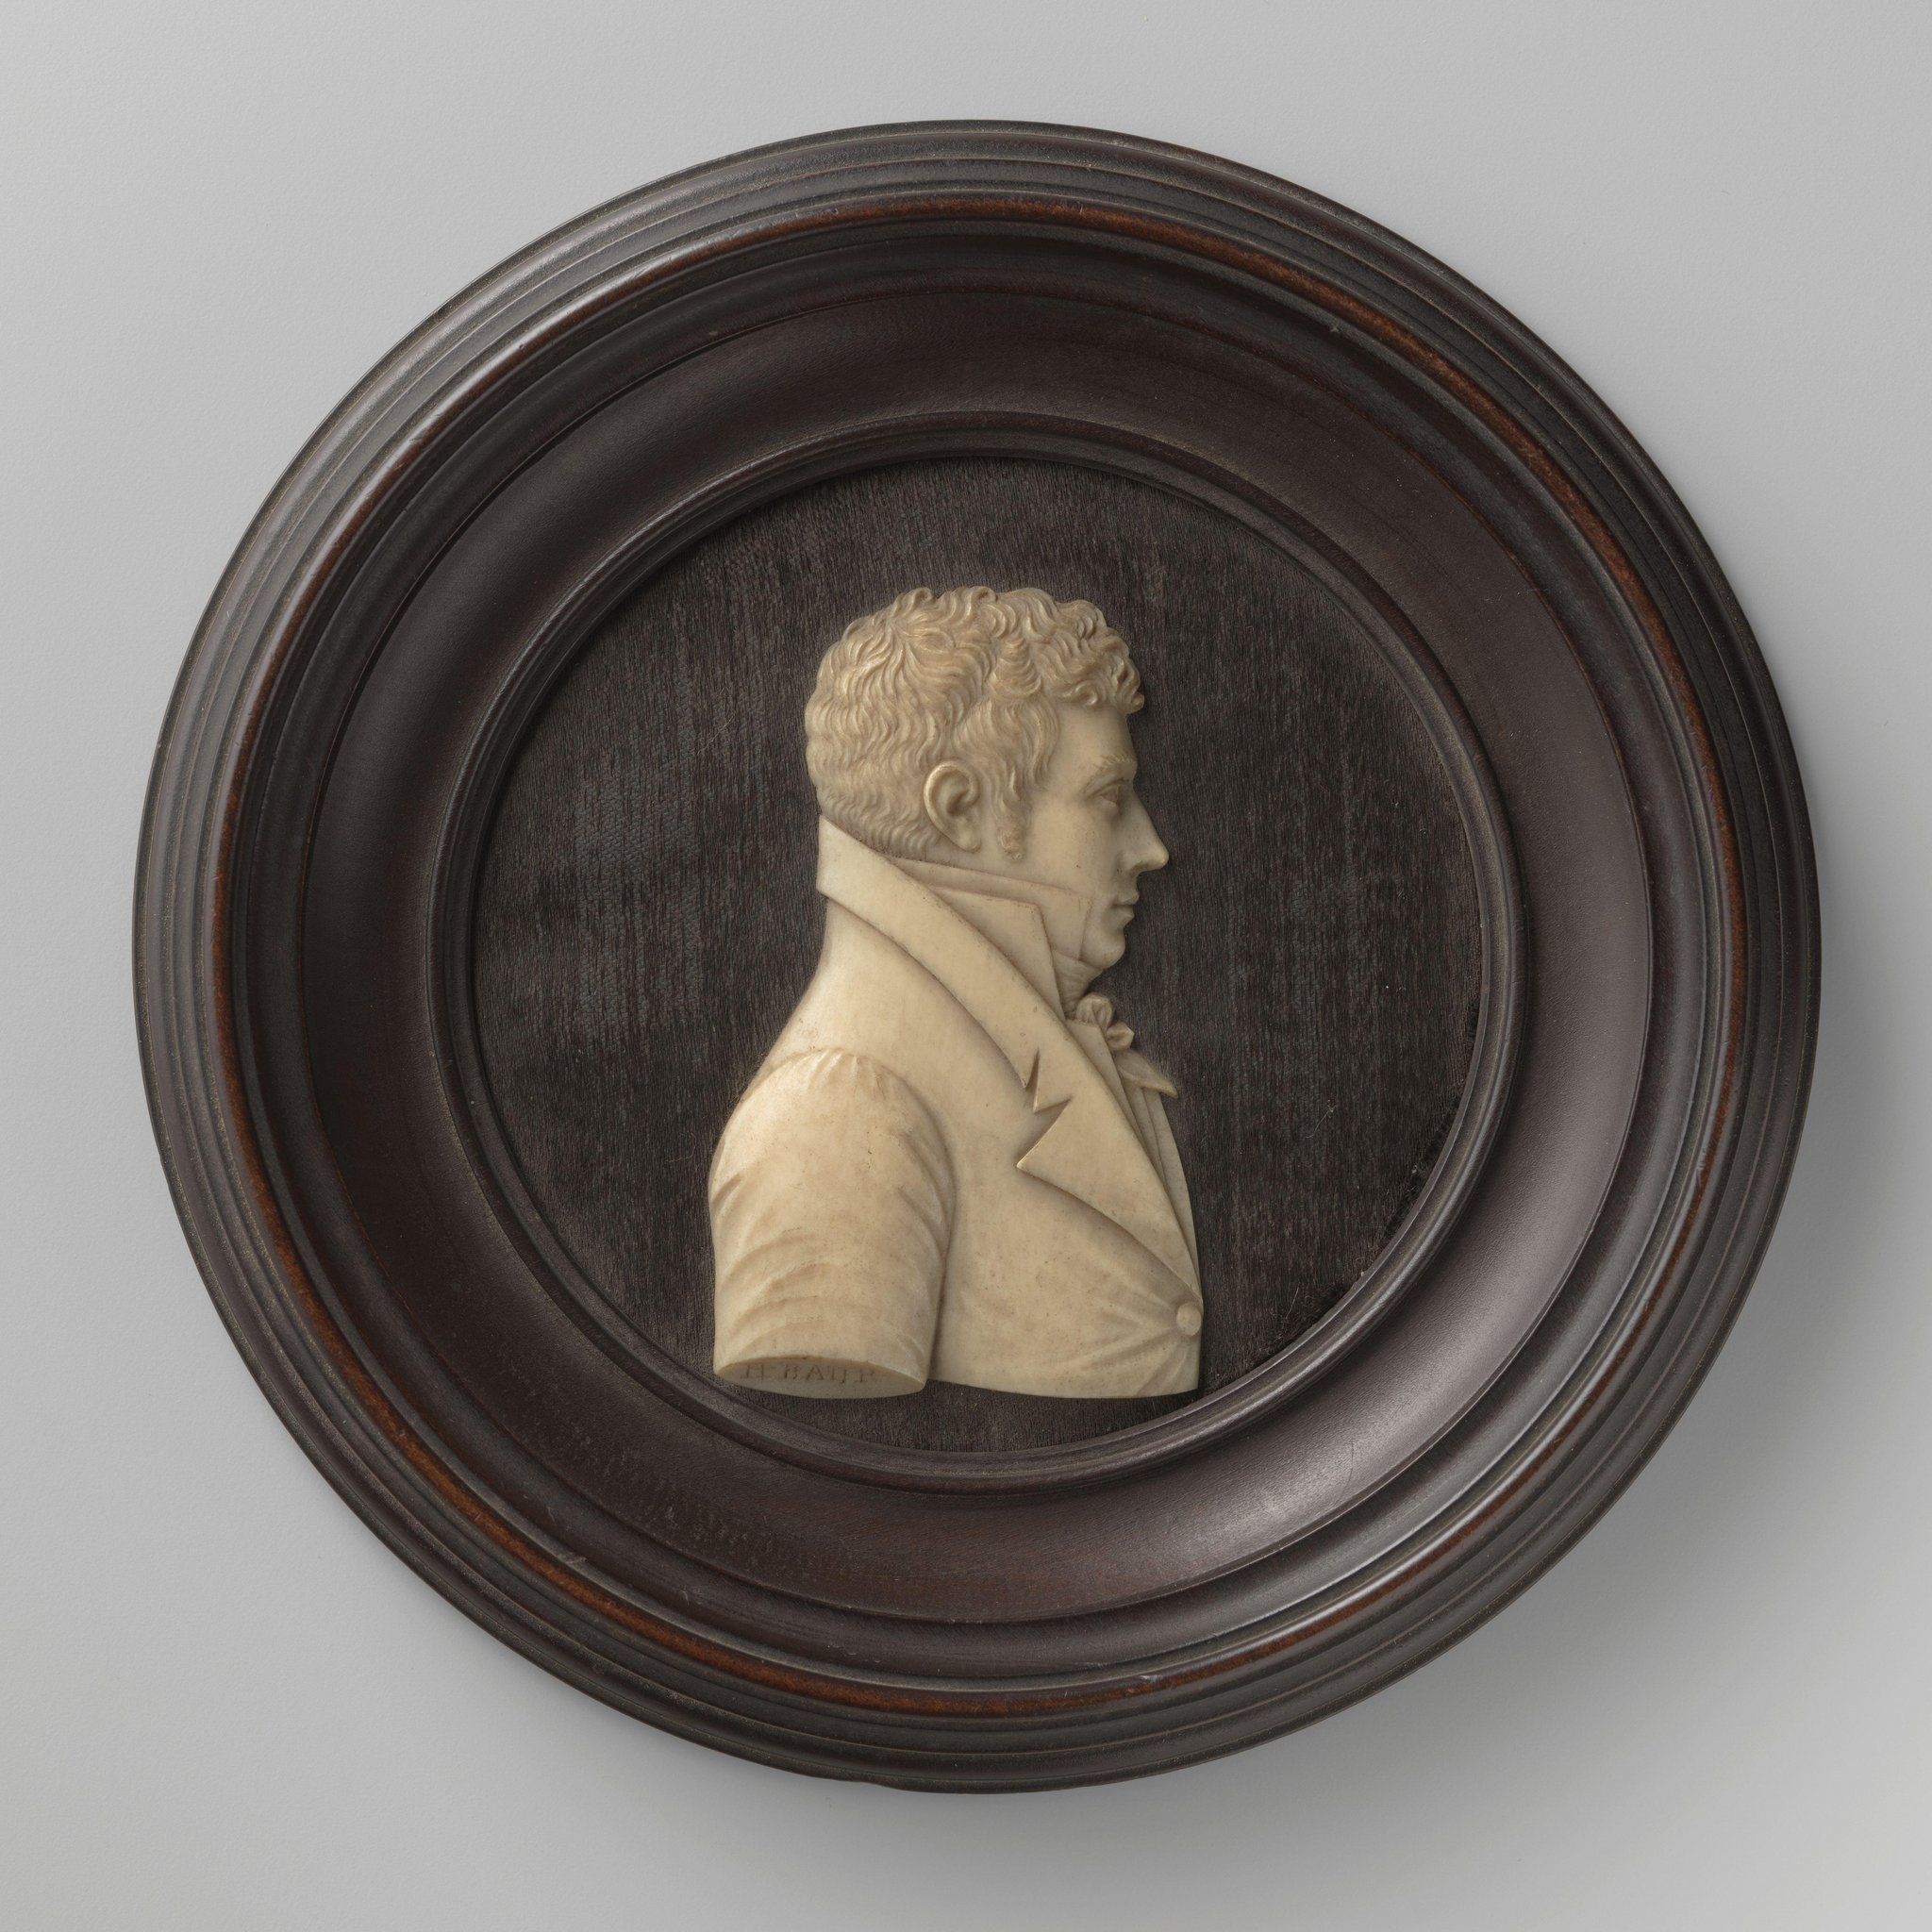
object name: locket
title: Portret en profil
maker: henricus baur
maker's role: ivory carver, painter, sculptor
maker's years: 1752-1823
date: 1800-1823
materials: ivory, textile, wood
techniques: cutting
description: Portret van ivoor, en profil, van een manspersoon. Gemonteerd op zwart satijn met een zwarte lijst eromheen.